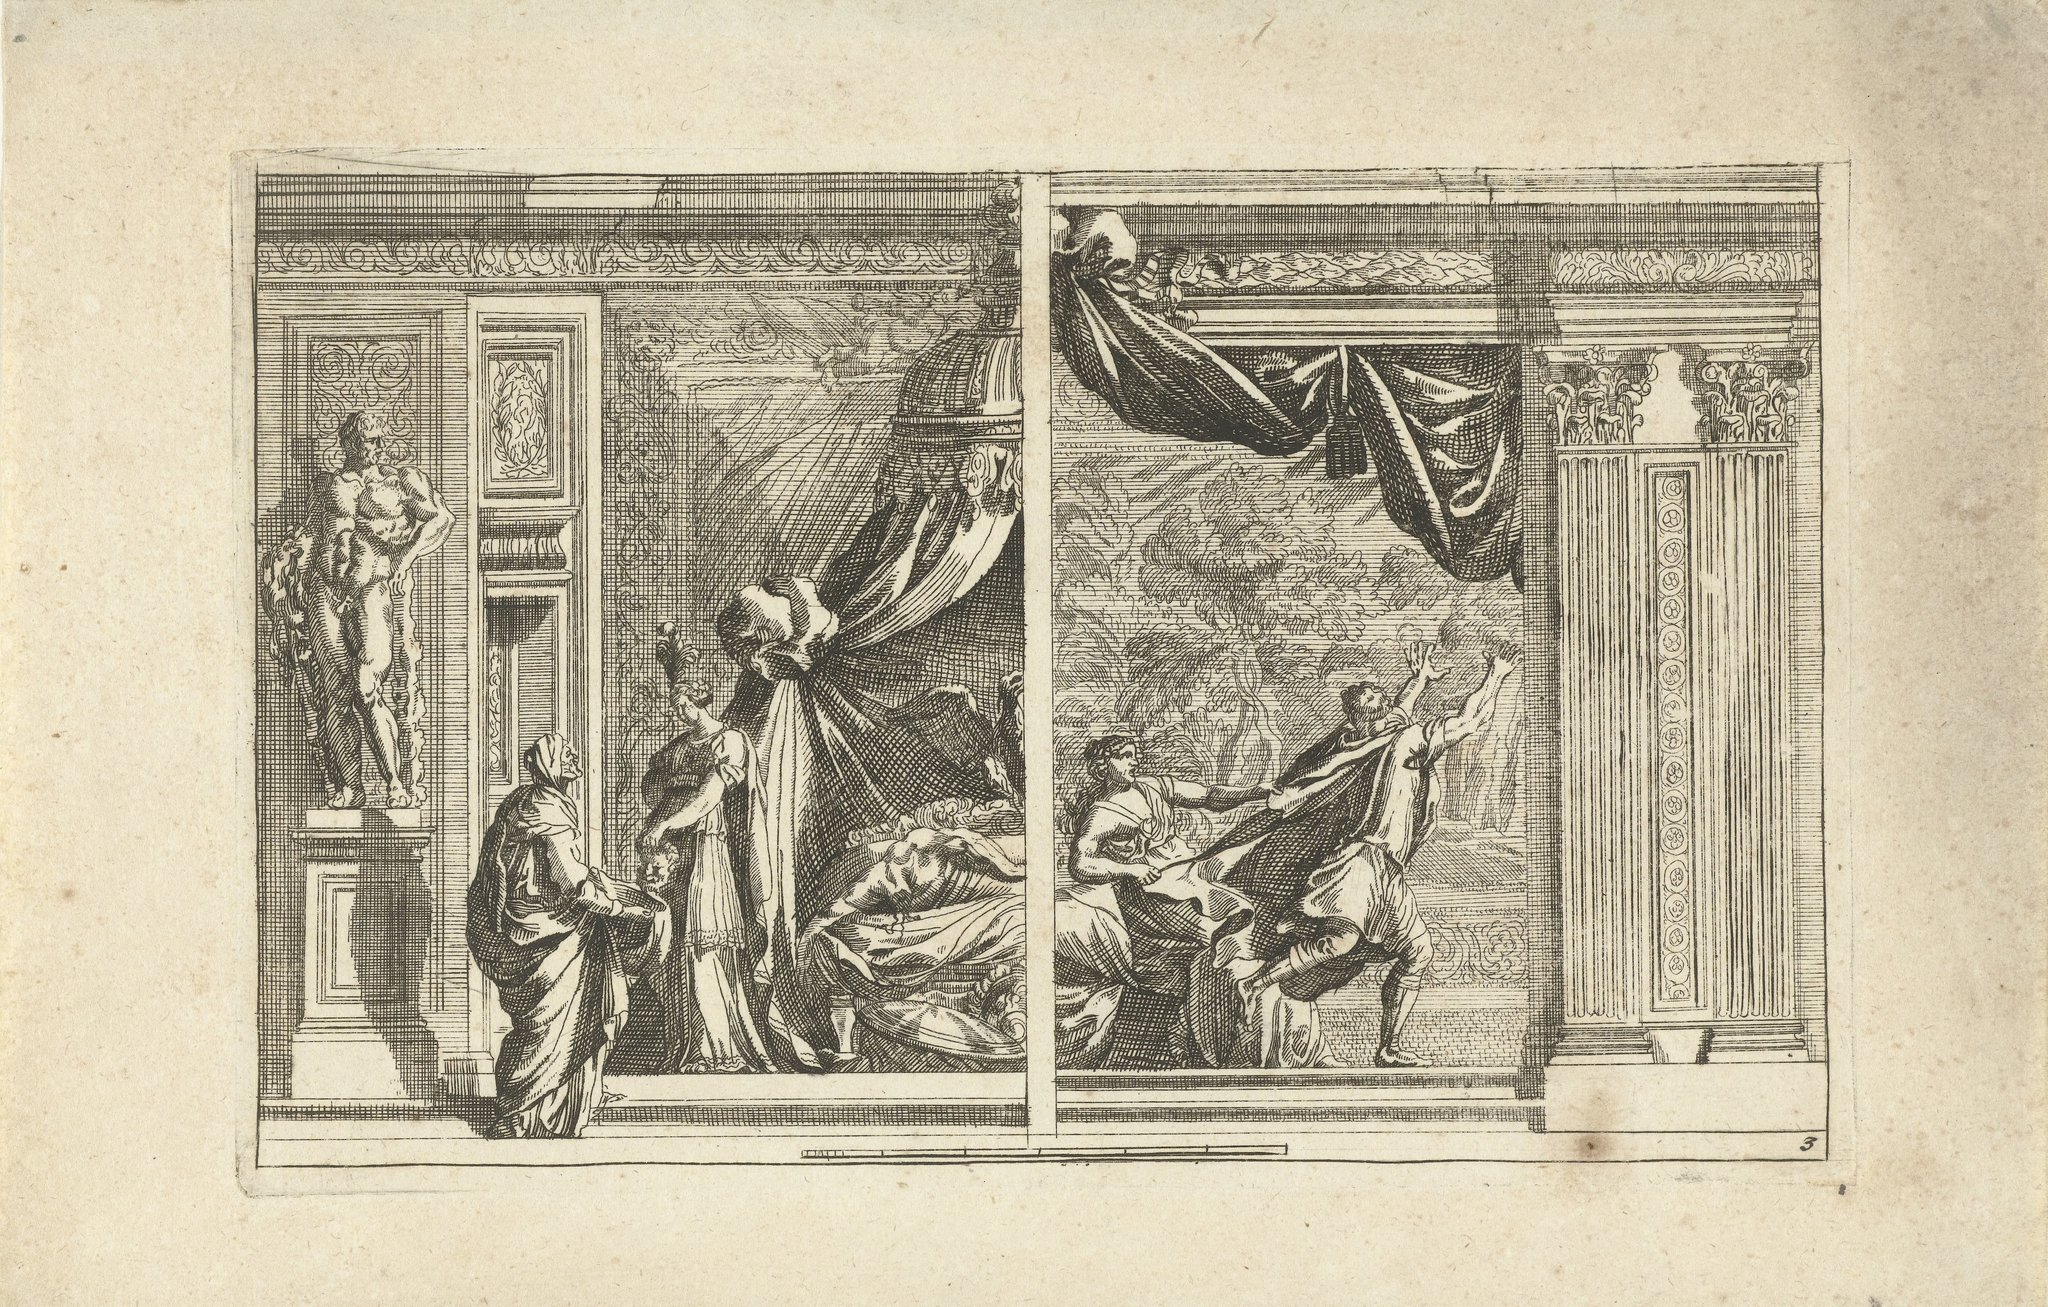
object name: print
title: Alkoof met variant voor rechterhelft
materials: paper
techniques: etching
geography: amsterdam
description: Links onthoofdt Judith Holofernes, rechts vlucht Jozef voor Potifars vrouw.